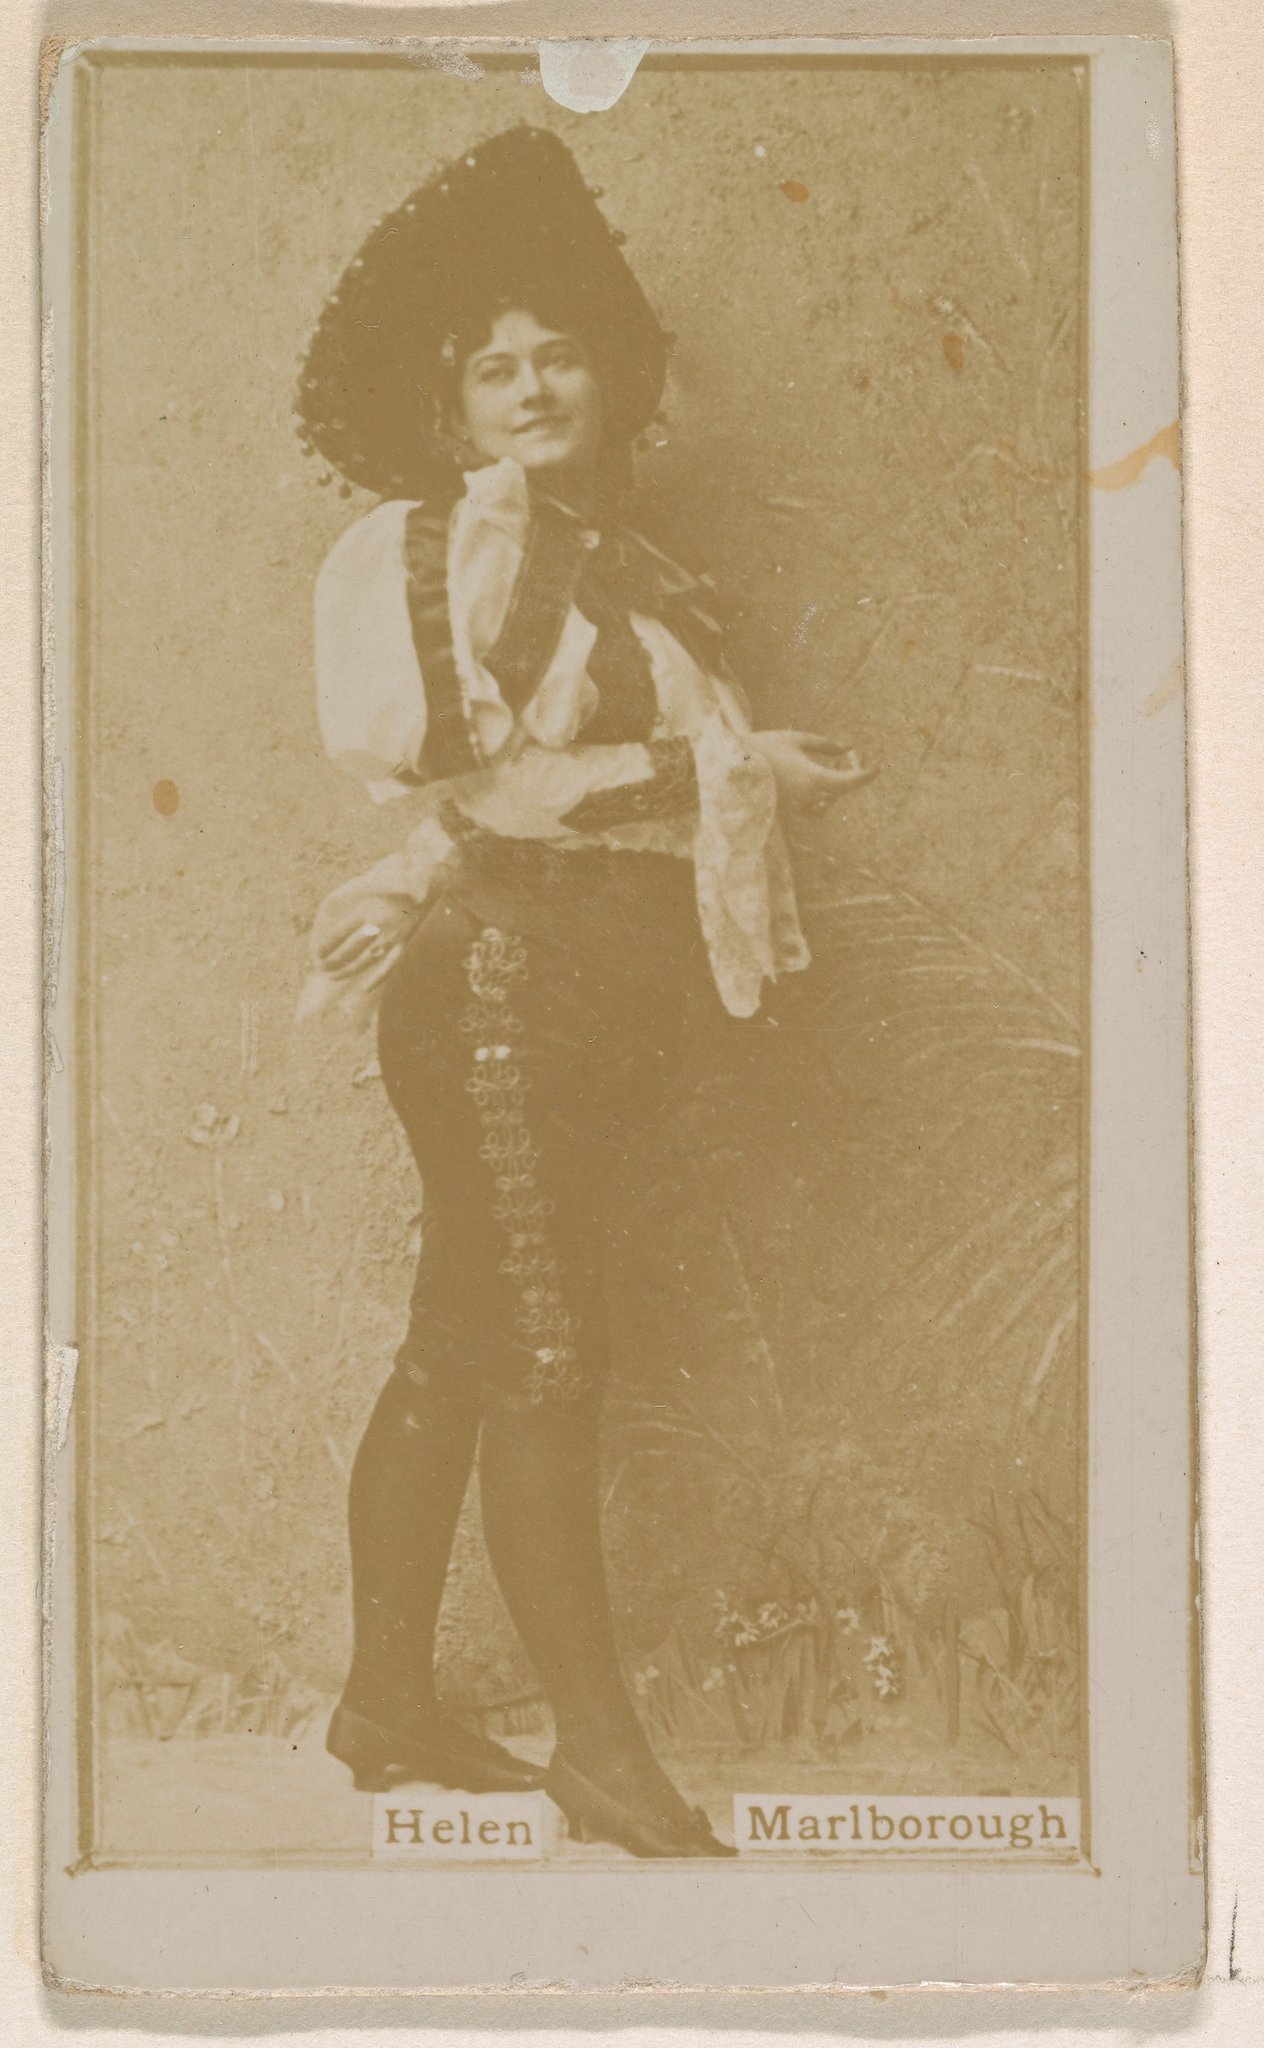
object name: photograph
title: Miss Helen Marlborough, from the Actresses series (N245) issued by Kinney Brothers to promote Sweet Caporal Cigarettes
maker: kinney brothers tobacco company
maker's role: publisher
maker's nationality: american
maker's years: 1869-2011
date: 1890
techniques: albumen silver print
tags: portraits,women,actresses